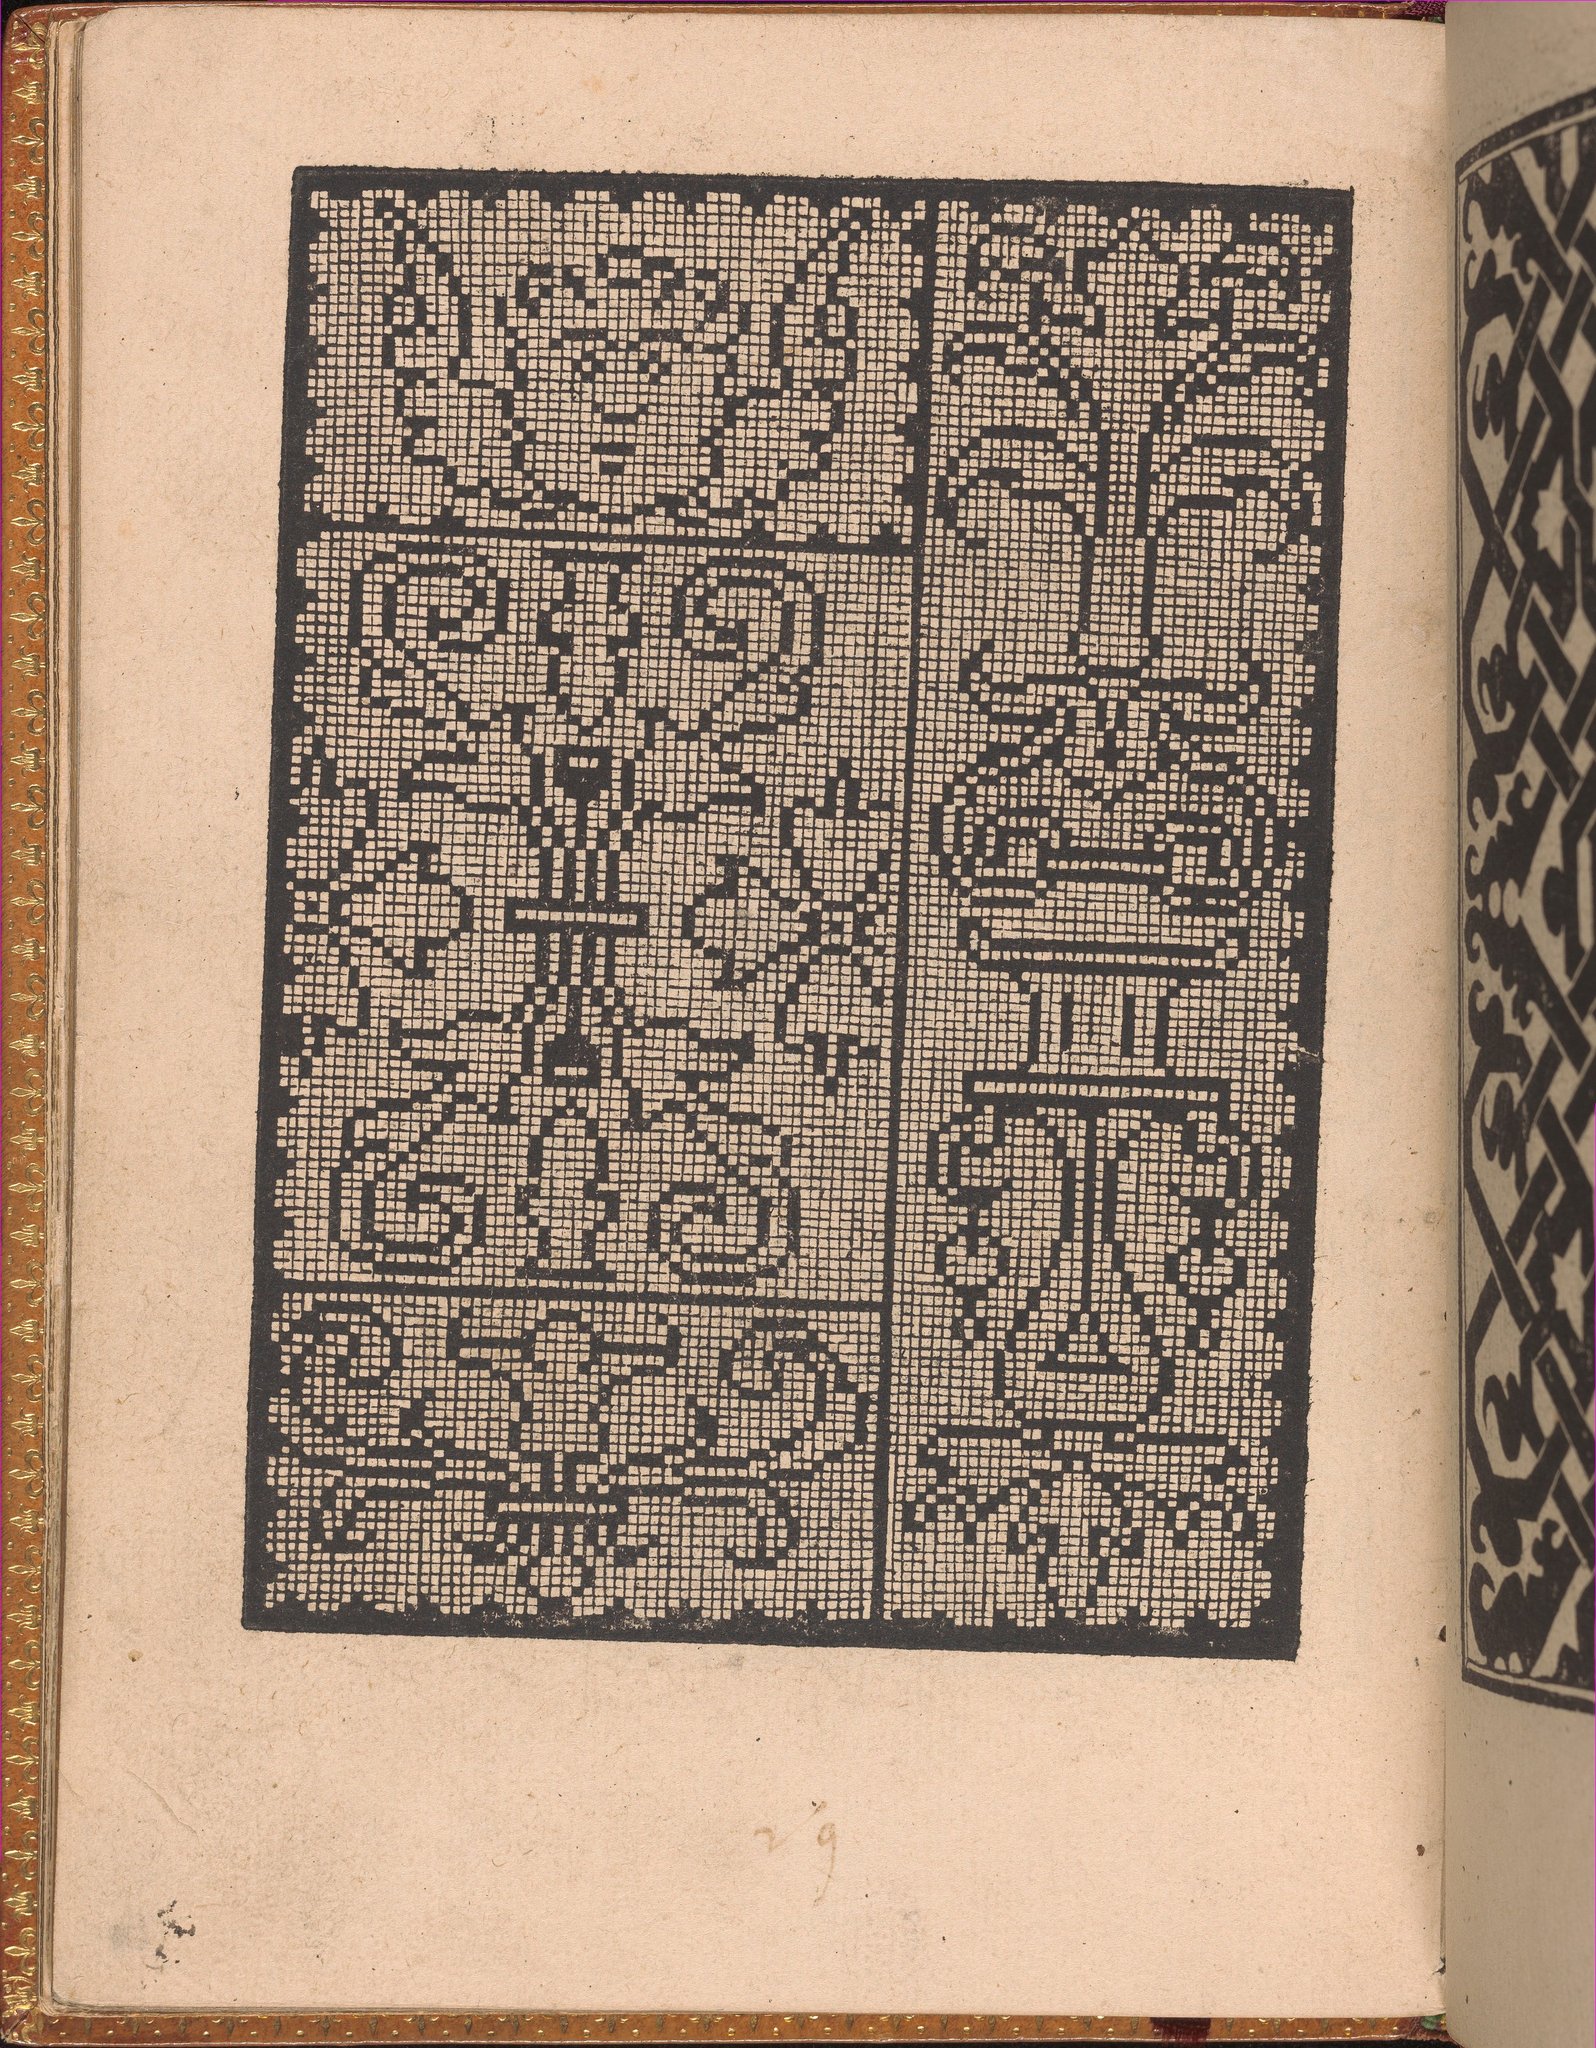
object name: book print ornament architecture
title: Convivio delle Belle Donne, page 19 (verso)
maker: nicolò zoppino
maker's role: publisher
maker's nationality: italian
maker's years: 1478-1544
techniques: woodcut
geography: italy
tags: flowers,vines,vases